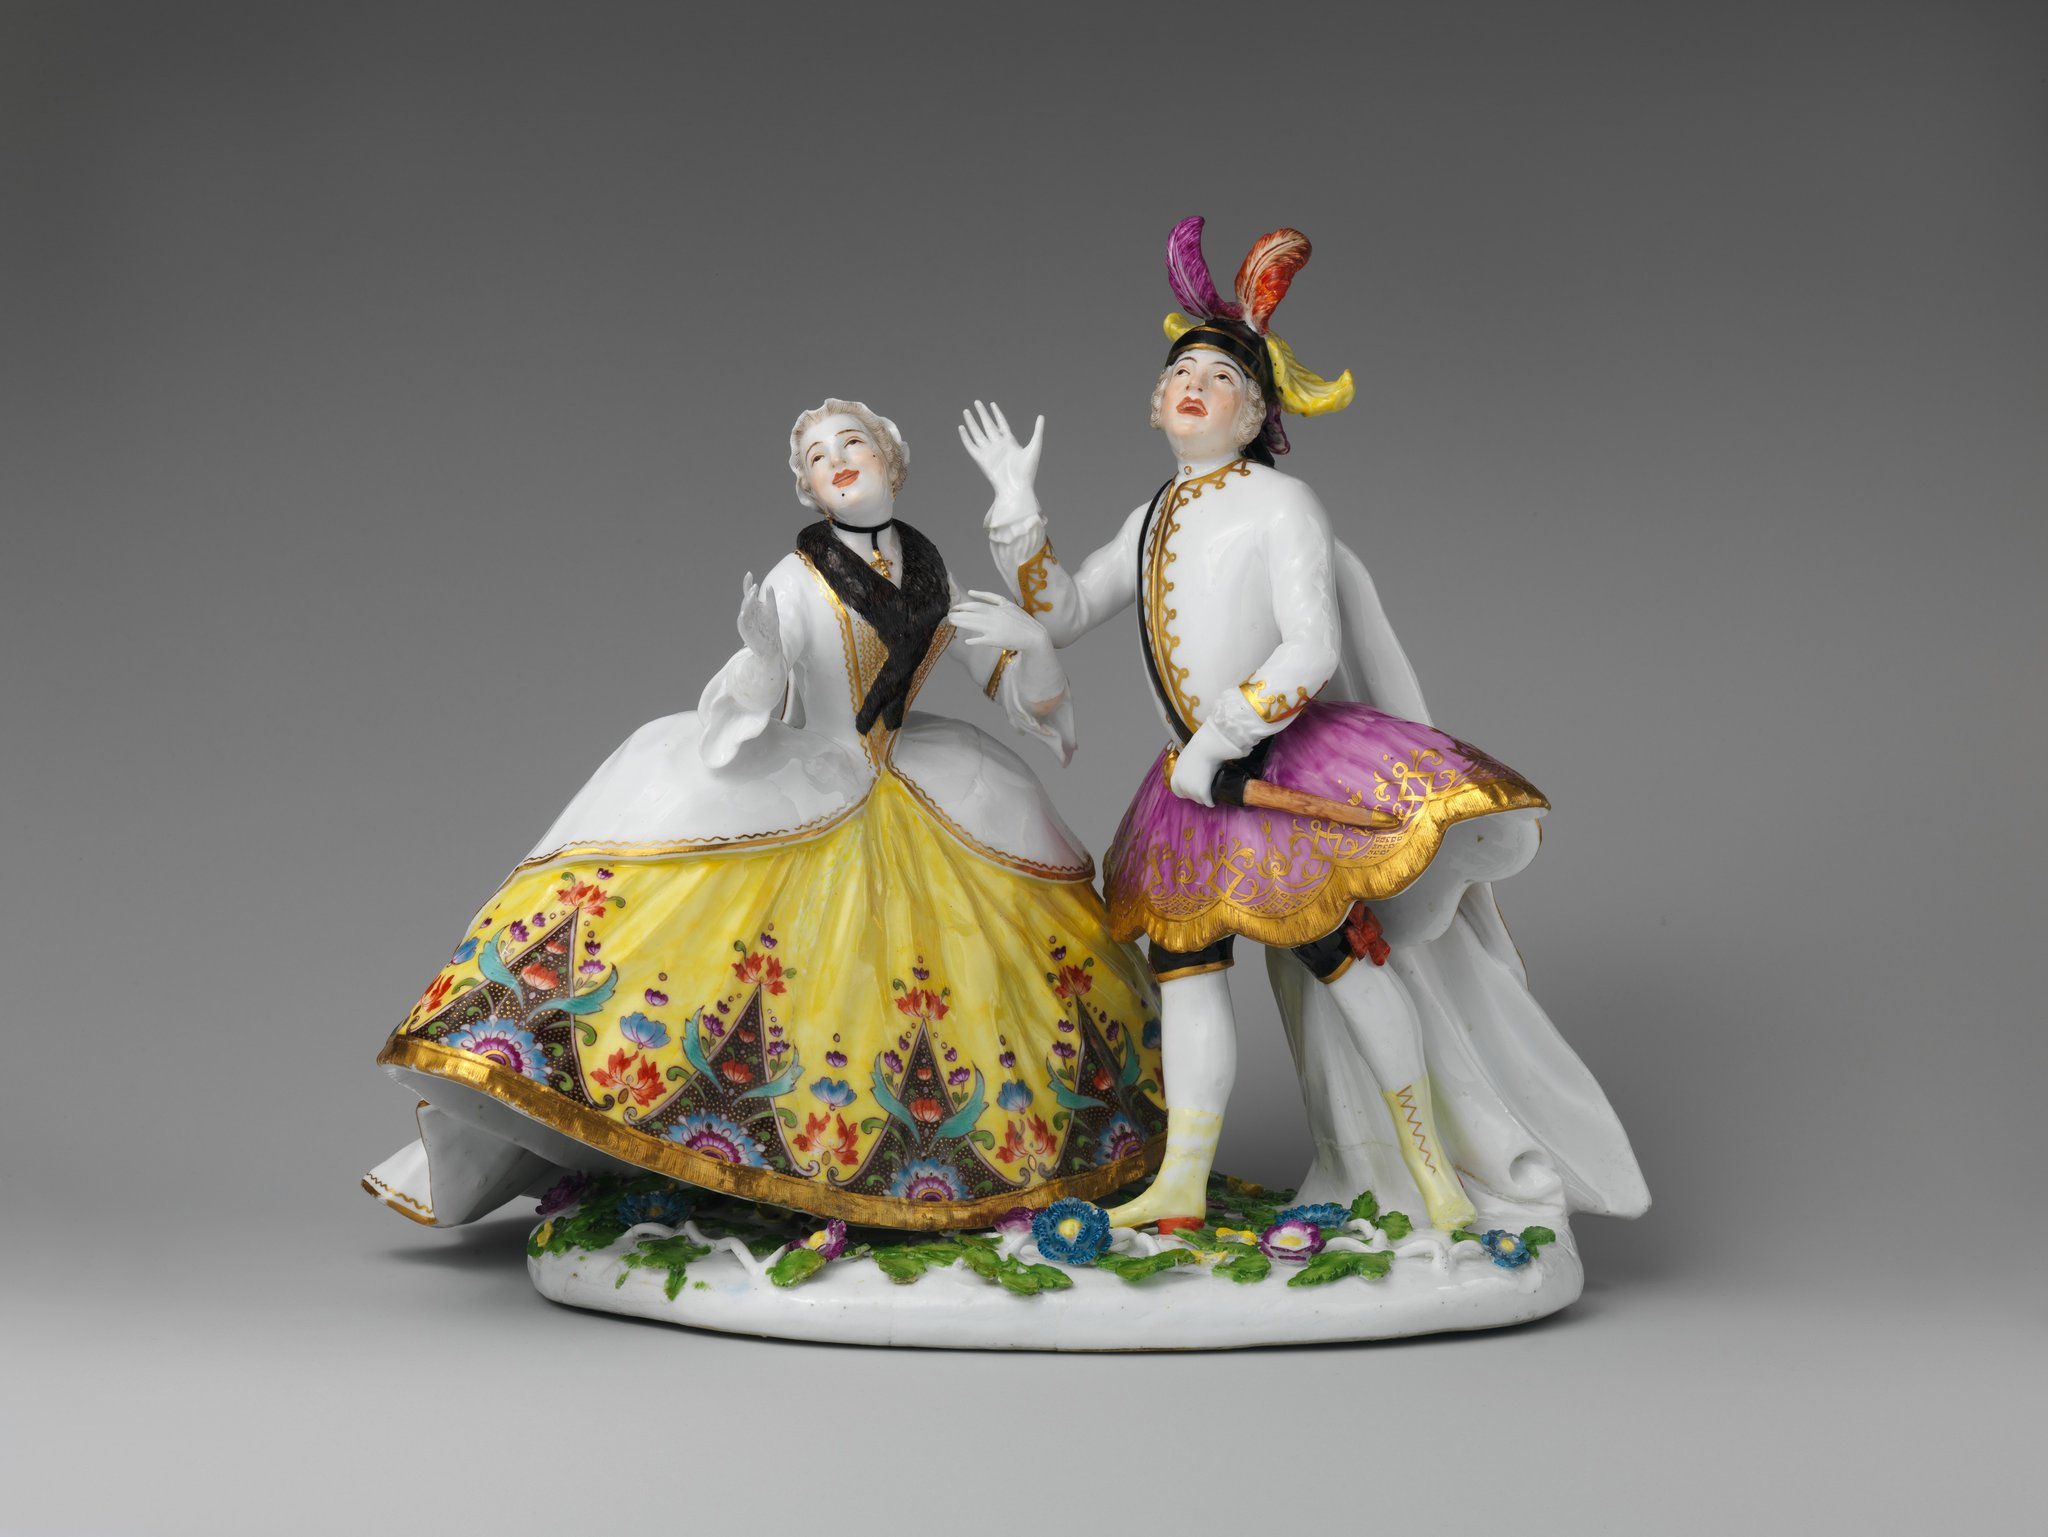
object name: group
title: Two Opera Singers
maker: meissen manufactory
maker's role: manufactory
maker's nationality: german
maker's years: 1710-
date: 1749-1750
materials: hard paste porcelain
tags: opera,men,women,singers